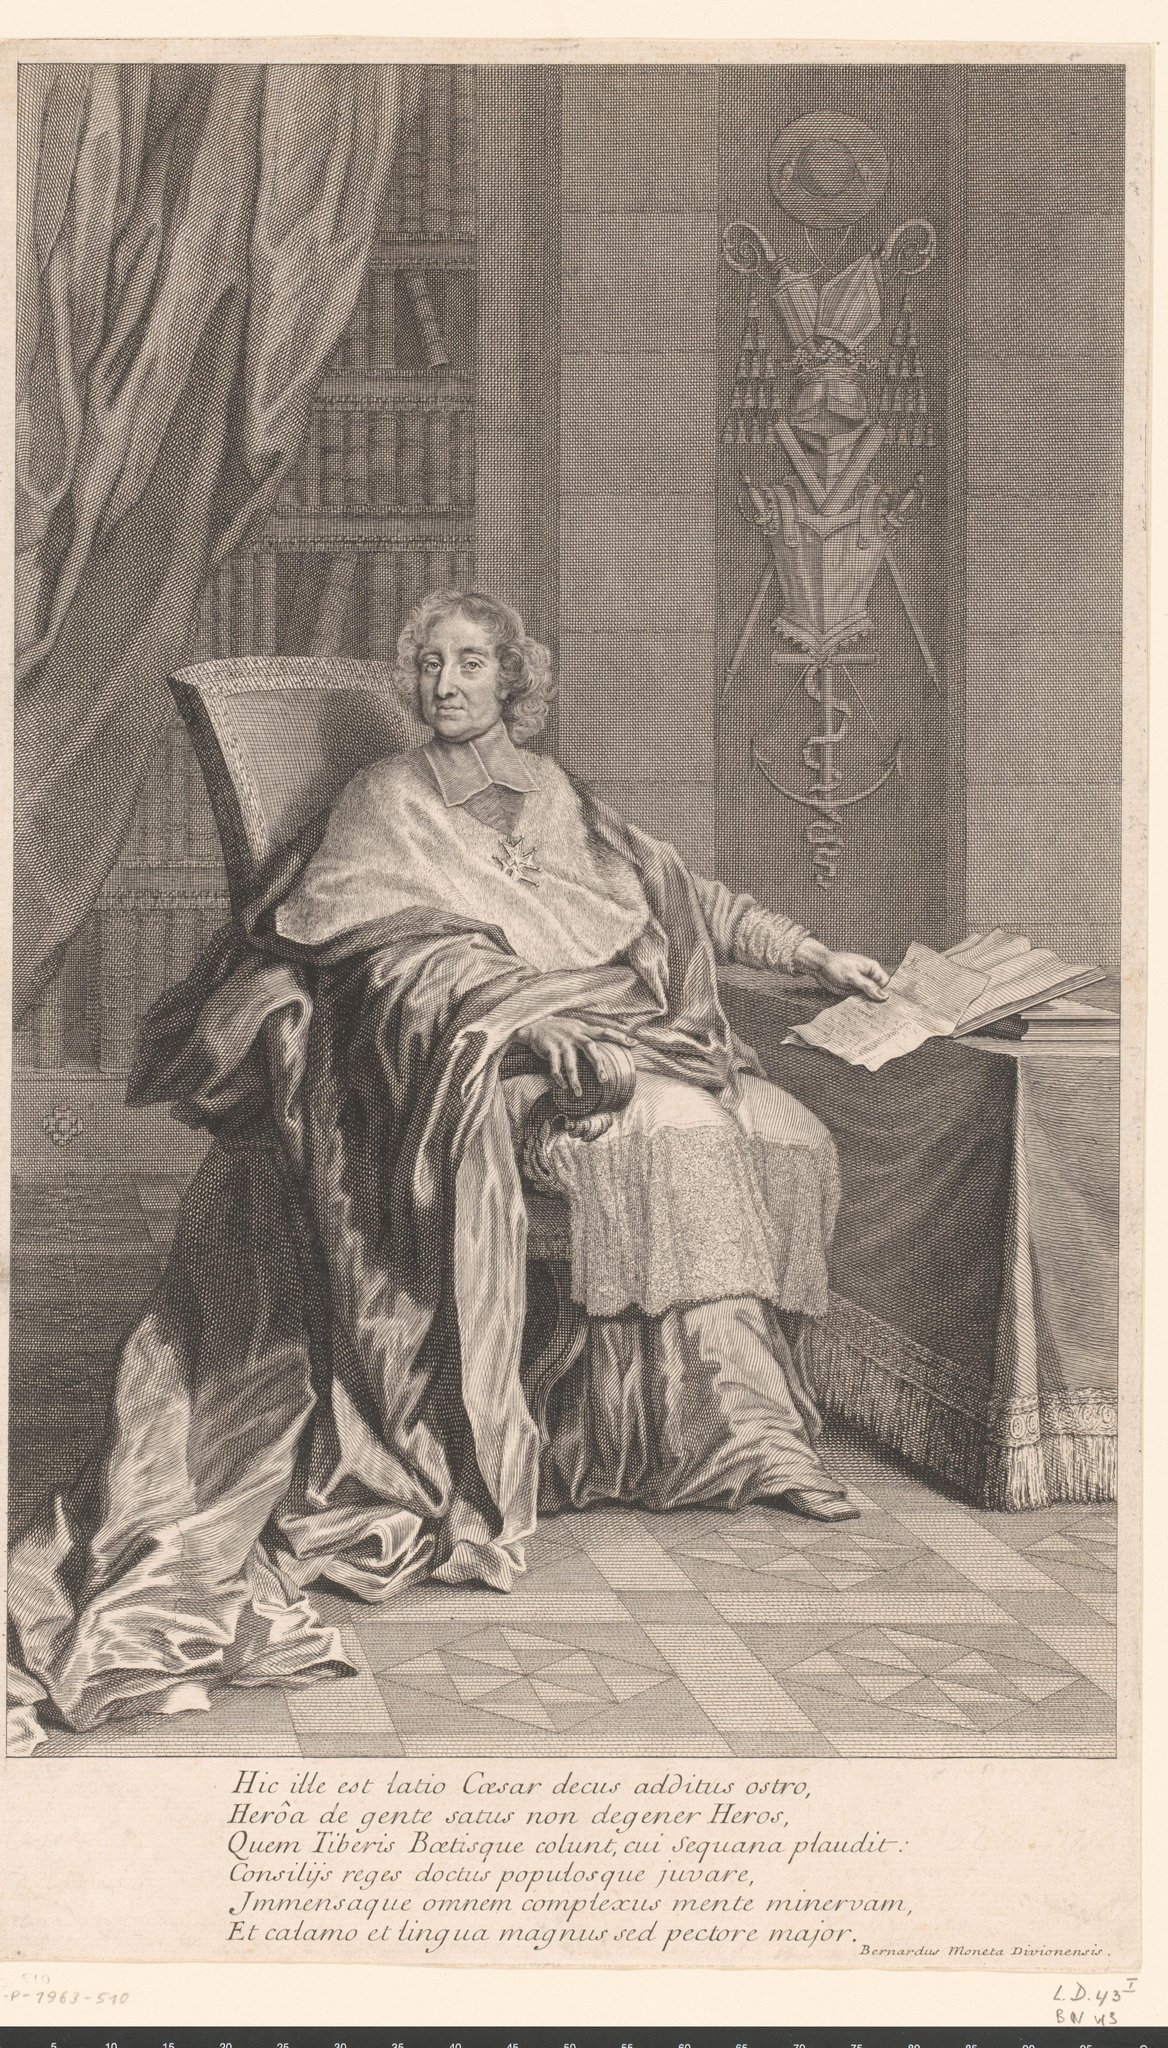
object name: print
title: Portret van César d'Estrées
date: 1687-1738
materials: paper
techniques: engraving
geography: france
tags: paris, priest, césar d' estrées, cardinal, historical persons, diplomacy, diplomat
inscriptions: collector's mark: Lugt 2228